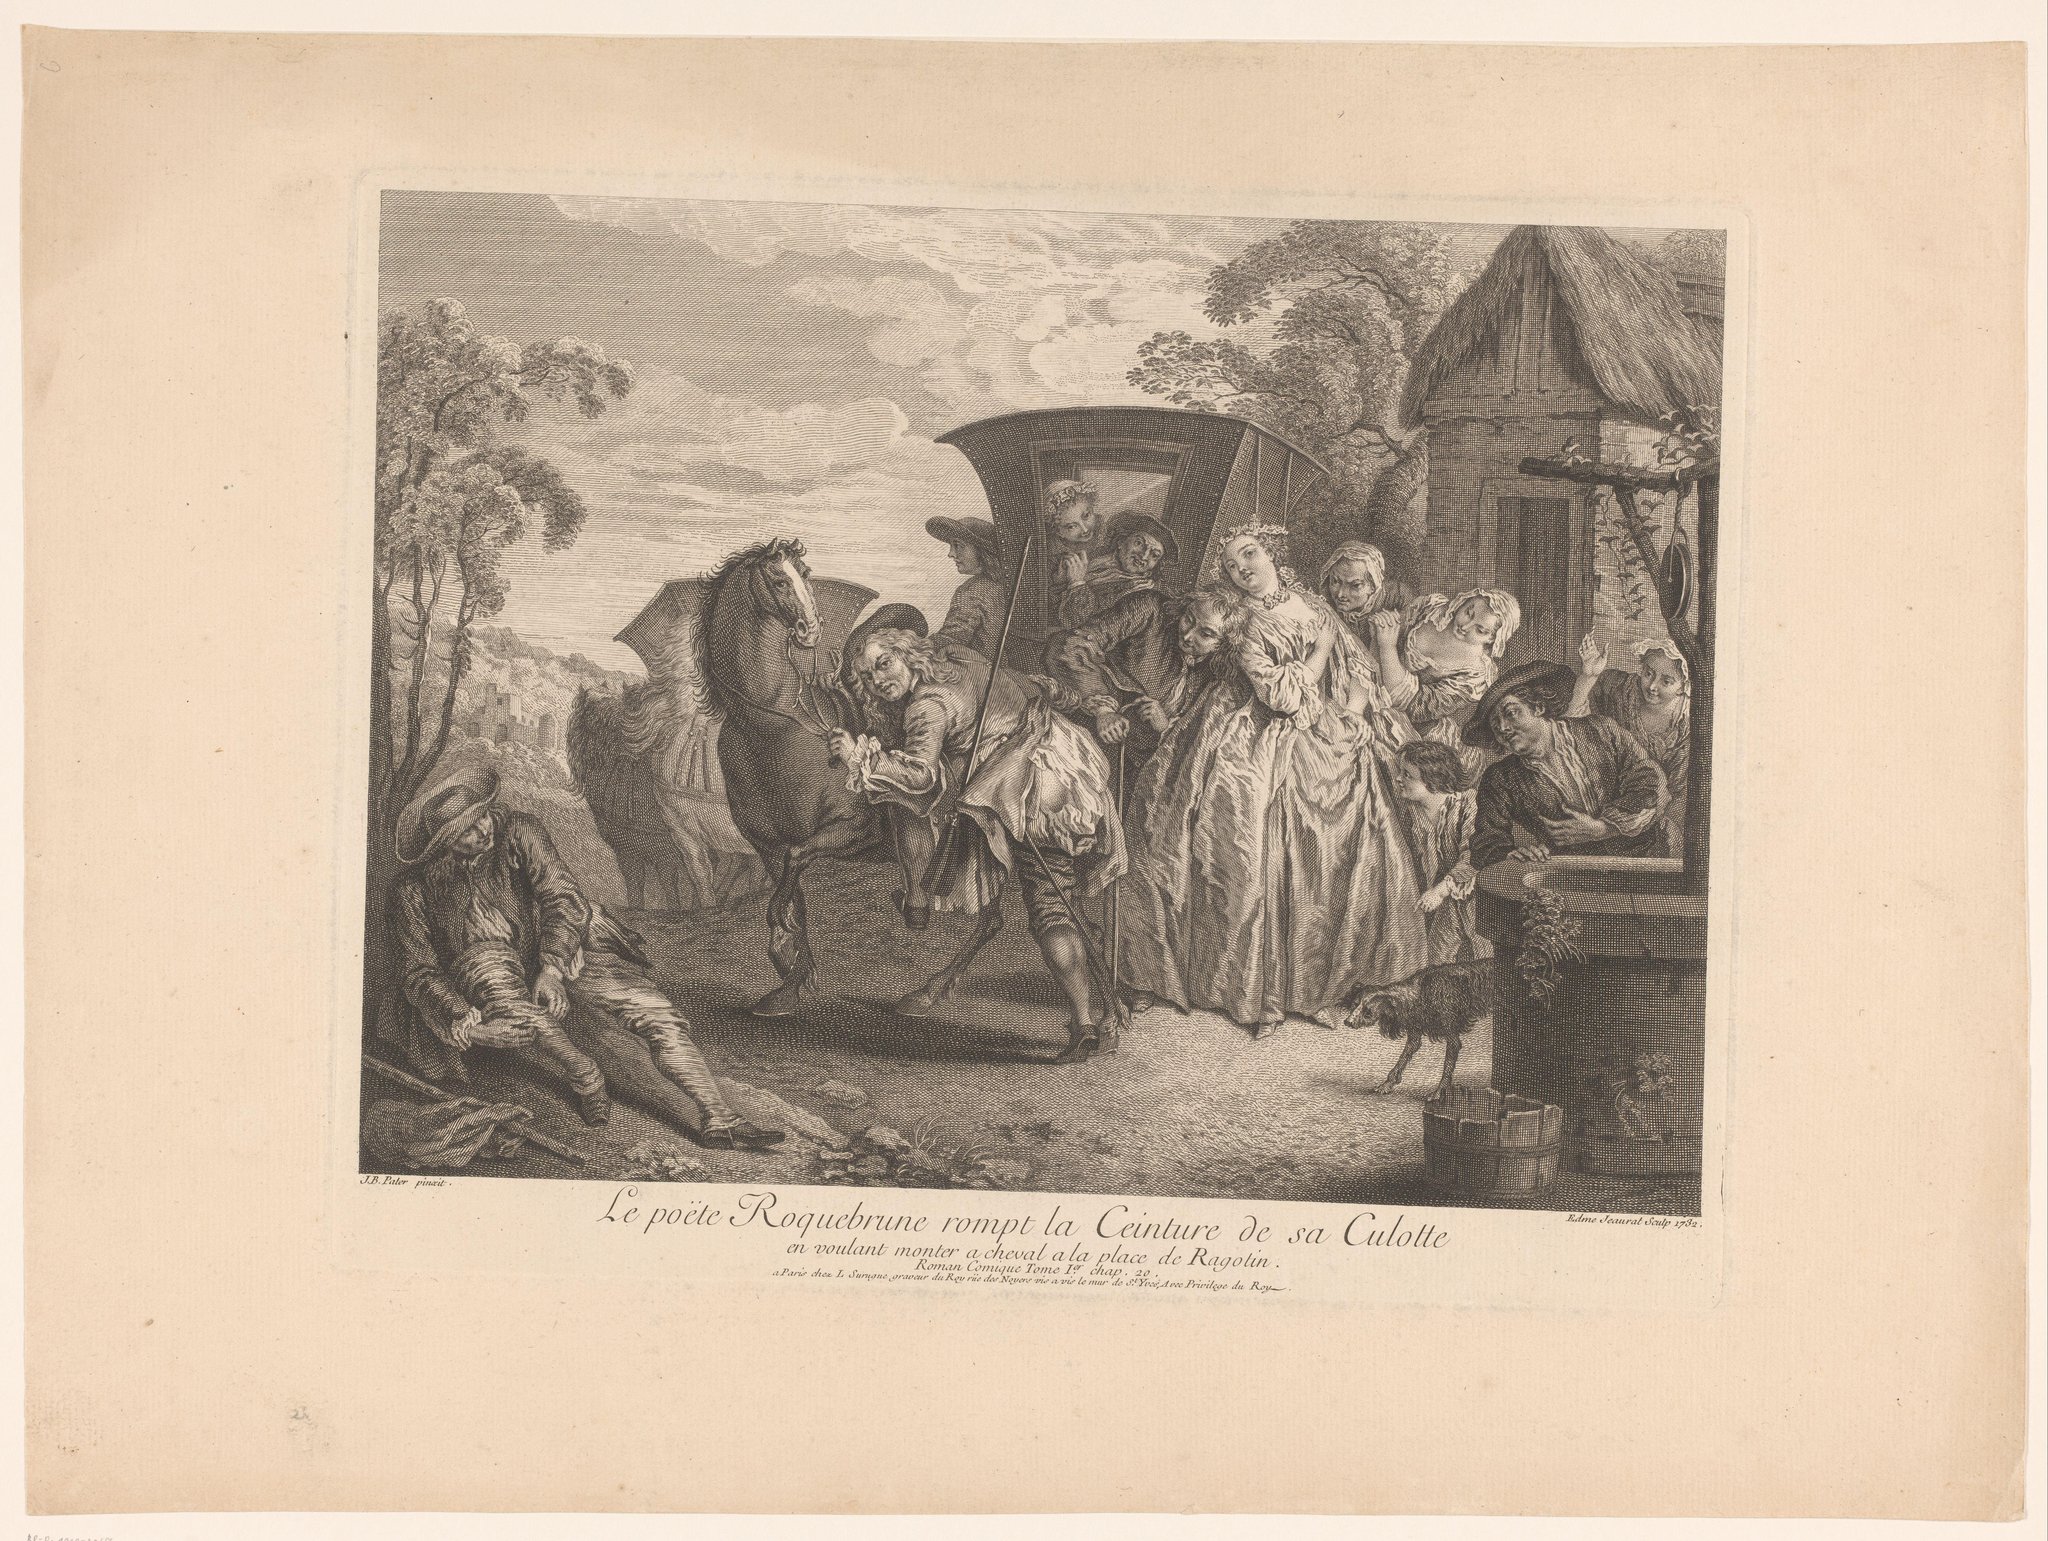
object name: print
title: Toneelscène uit Paul Scarron's Roman Comique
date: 1732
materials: paper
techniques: engraving, etching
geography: france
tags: (scarron) specific works of literature (with author, title), passenger carriage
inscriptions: collector's mark: Lugt 2233